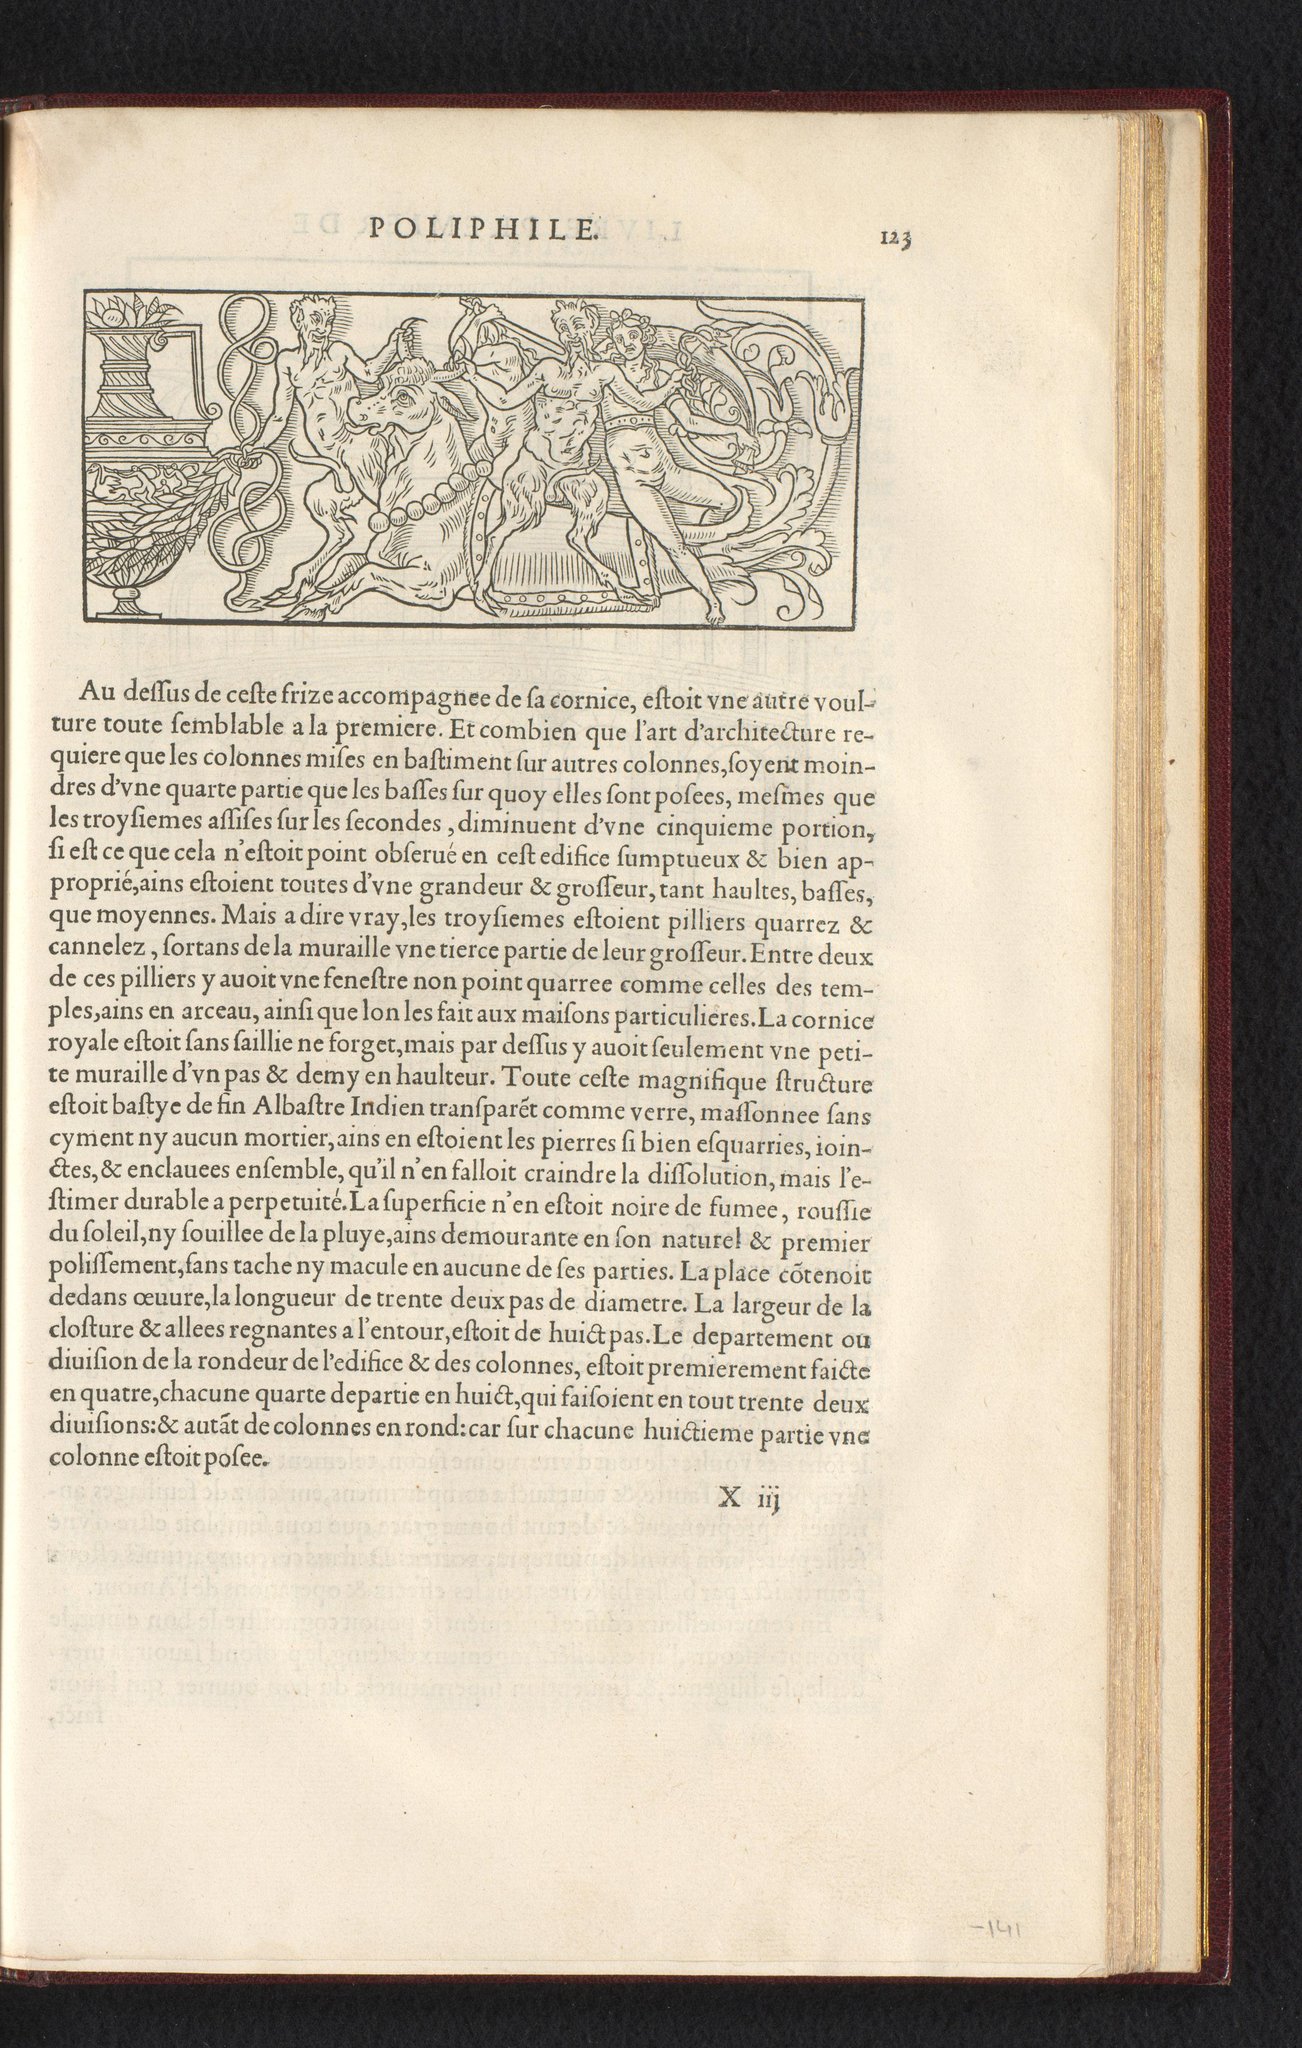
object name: book illustration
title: Fries met satyrs en een nimf bij een stier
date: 1546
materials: paper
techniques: letterpress printing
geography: paris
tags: bull, satyrs, fauns, sileni, (scenes from) specific works of literature: colonna, hypnerotomachia poliphili, nymphs (in general); 'ninfe in commune' (ripa)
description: Prent uit: Colonna, Francesco. Hypnerotomachie ou discours du songe de Poliphile, deduisant comme amour le combat a l'occasion de Polia. Parijs: Jacques Kerver, 1546, recto fol. 123.